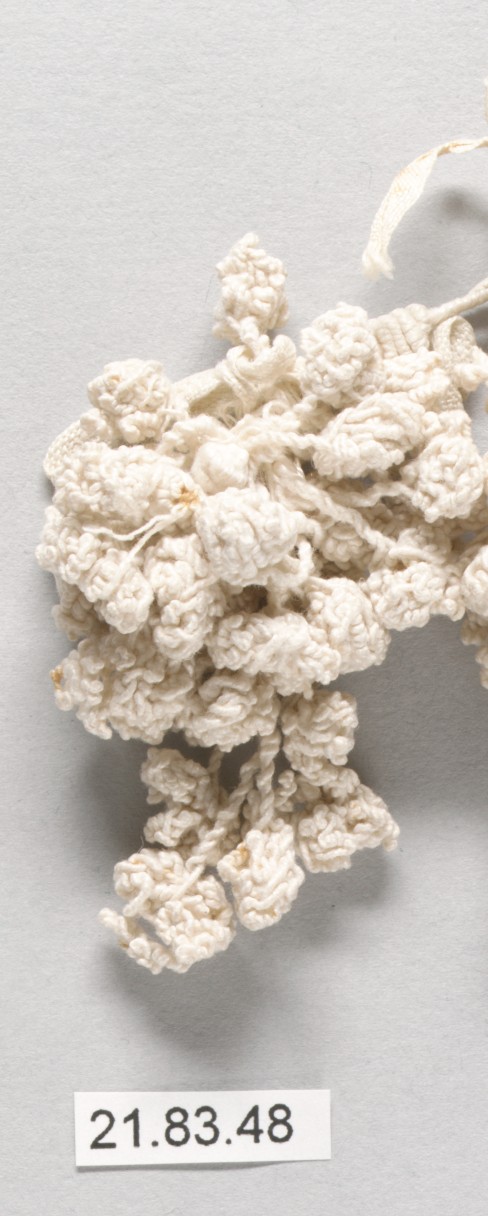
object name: tassel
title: Pair of tassels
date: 1601-1700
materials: linen